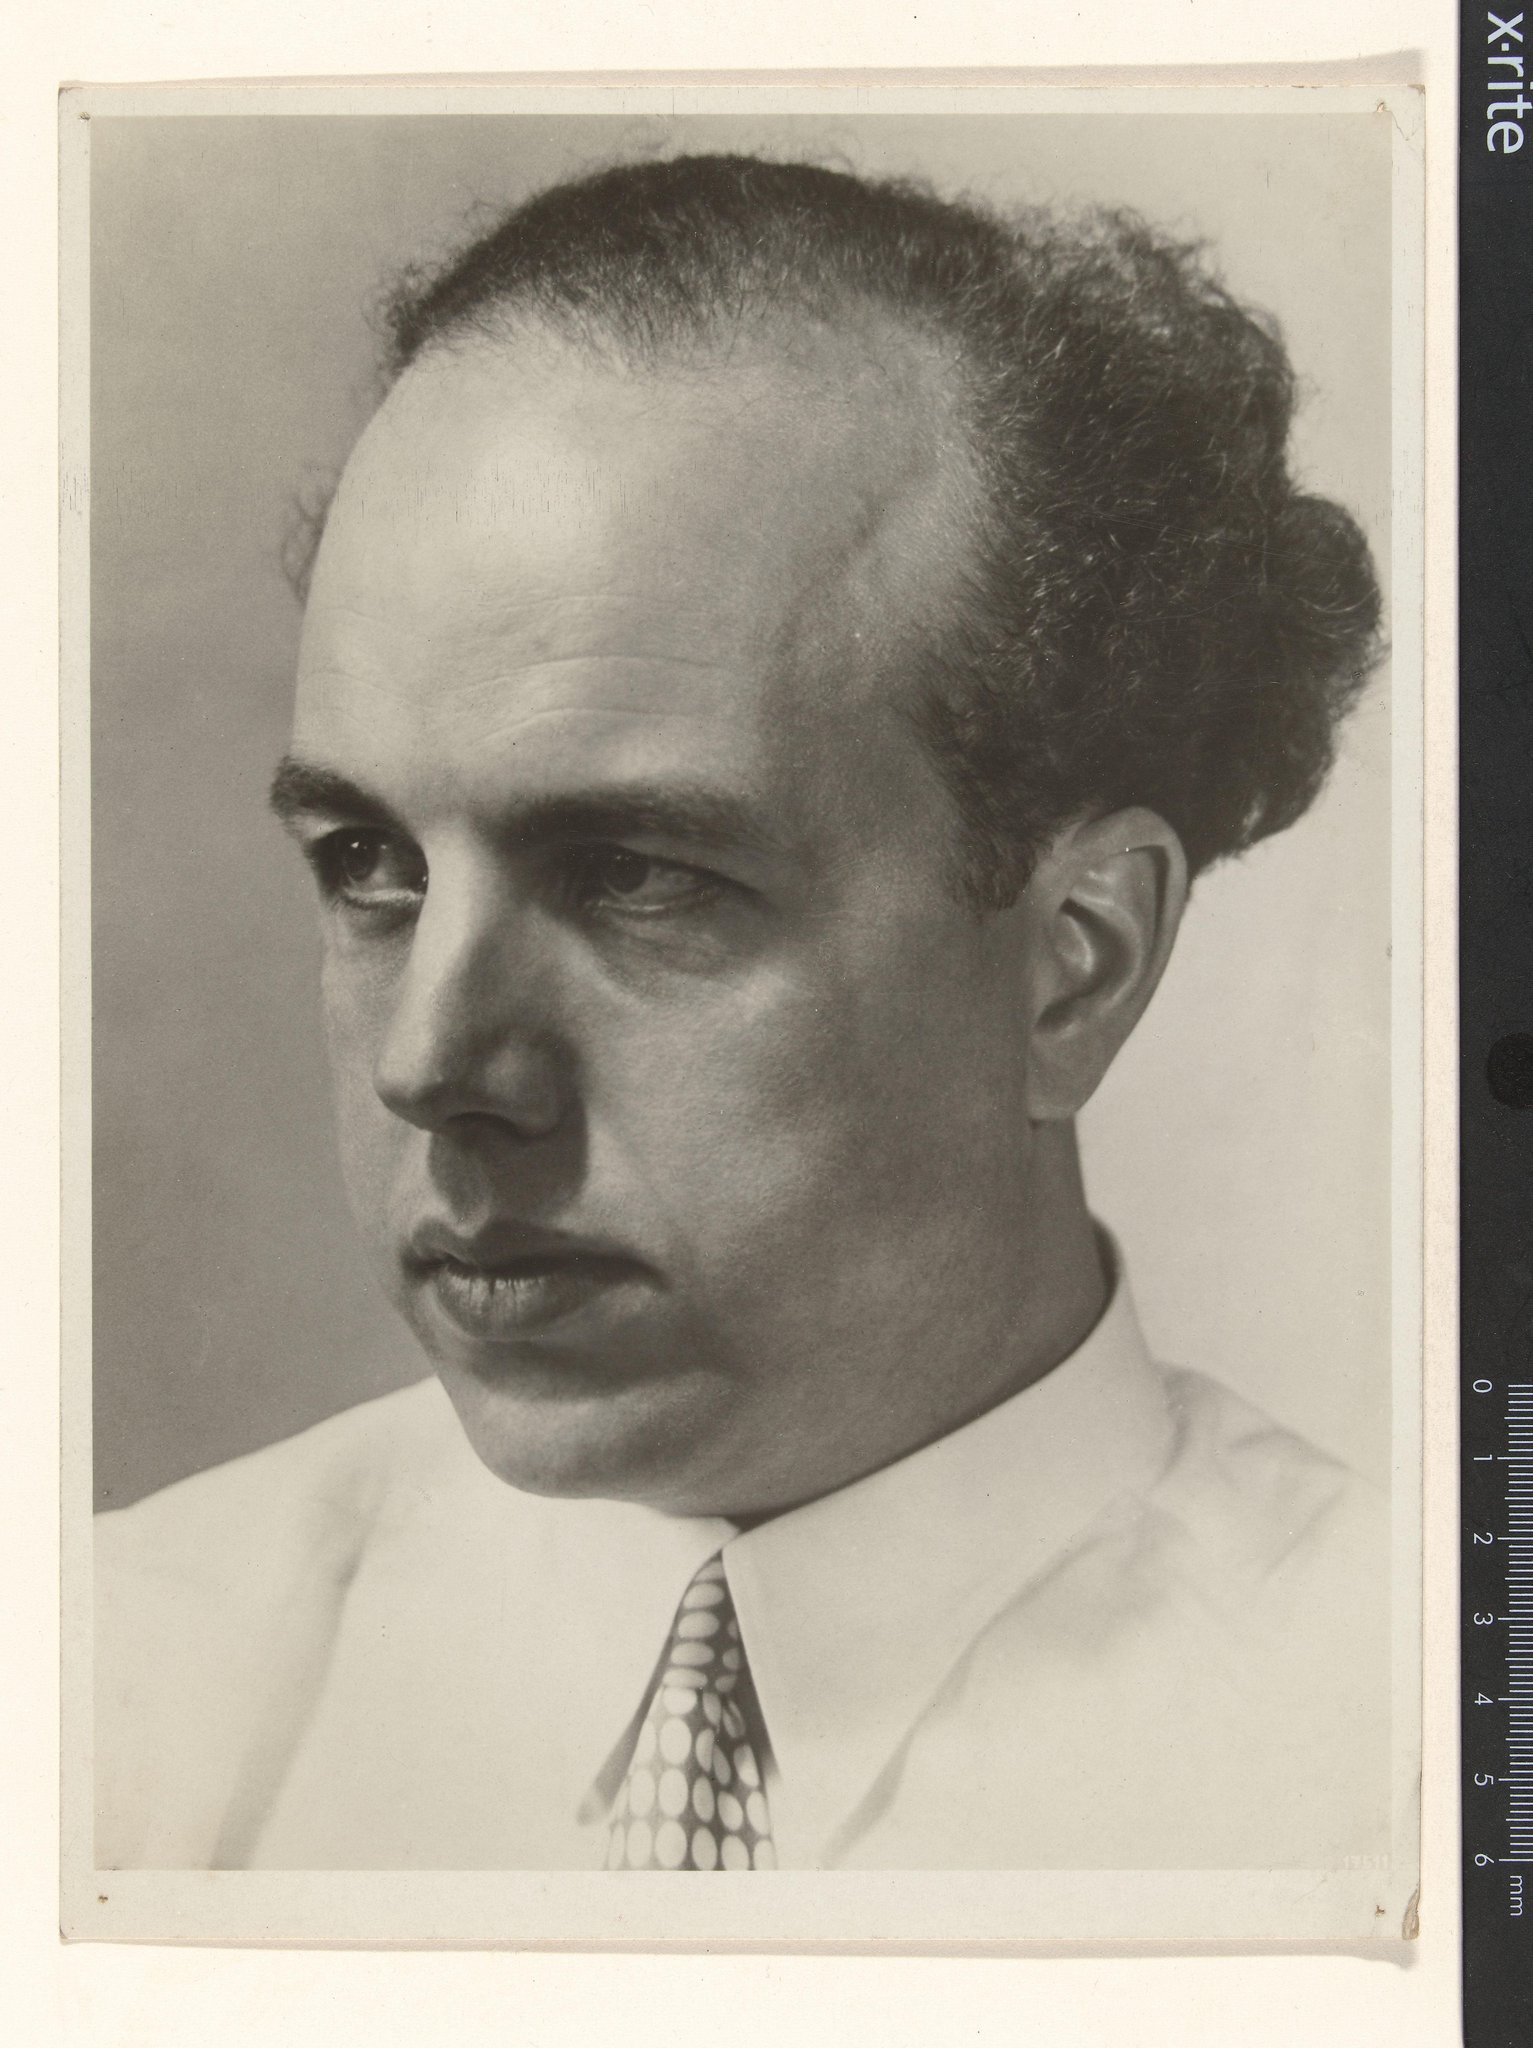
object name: photograph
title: Portret van K. Sooss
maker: Anonymous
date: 1901-1985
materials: photographic support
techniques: gelatin silver print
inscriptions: inscription: ‘K. Sooss, geb. 1901 Duits danser en choreograaf, leider eigen ballet sinds 1933’